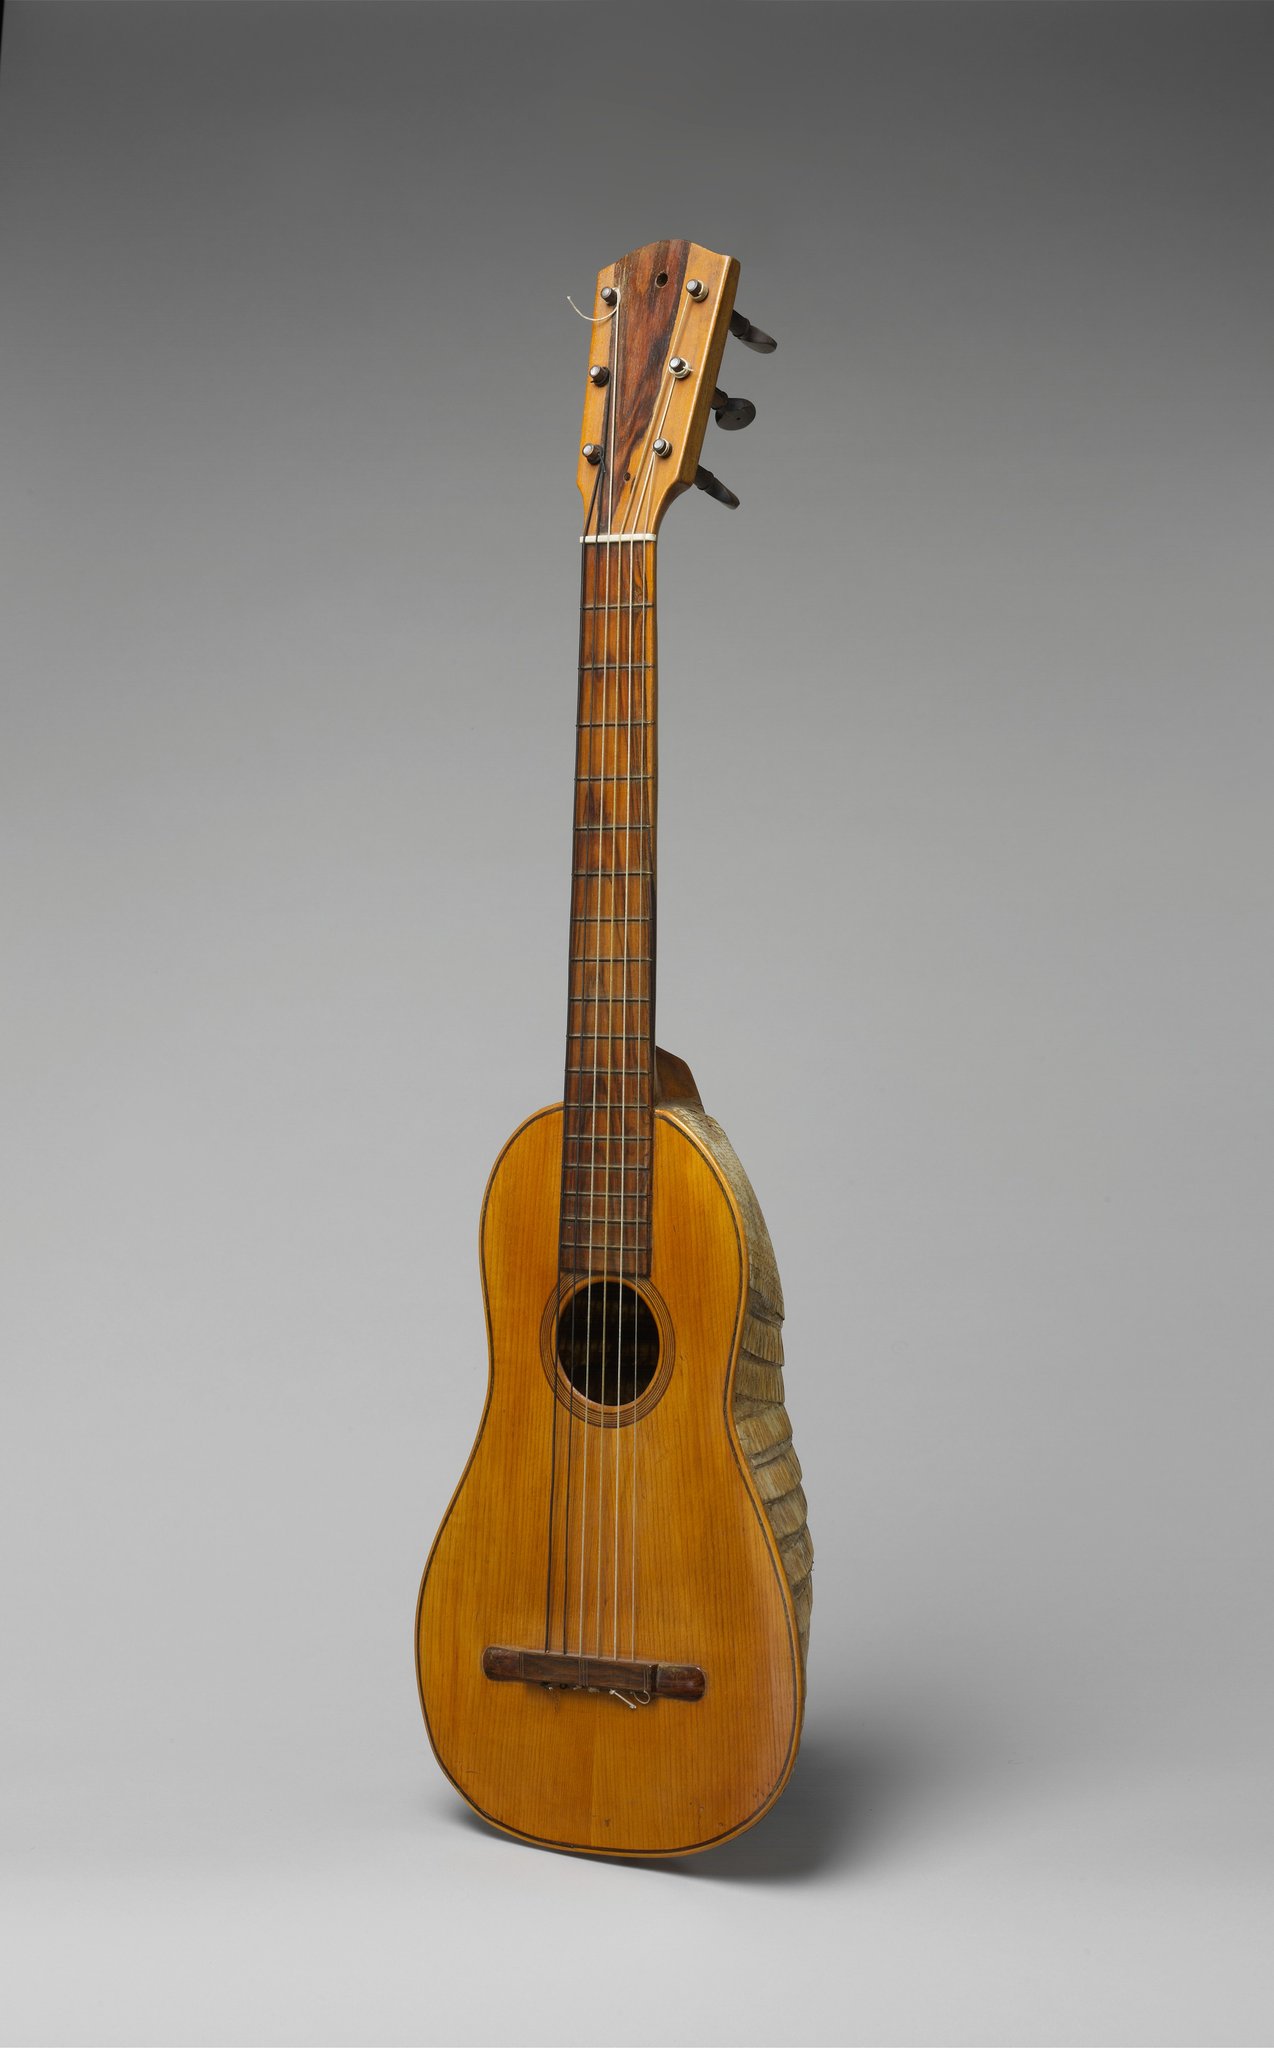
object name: charango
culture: mexican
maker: marcos manufactory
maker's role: maker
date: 1867-1900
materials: shell, wood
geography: mexico